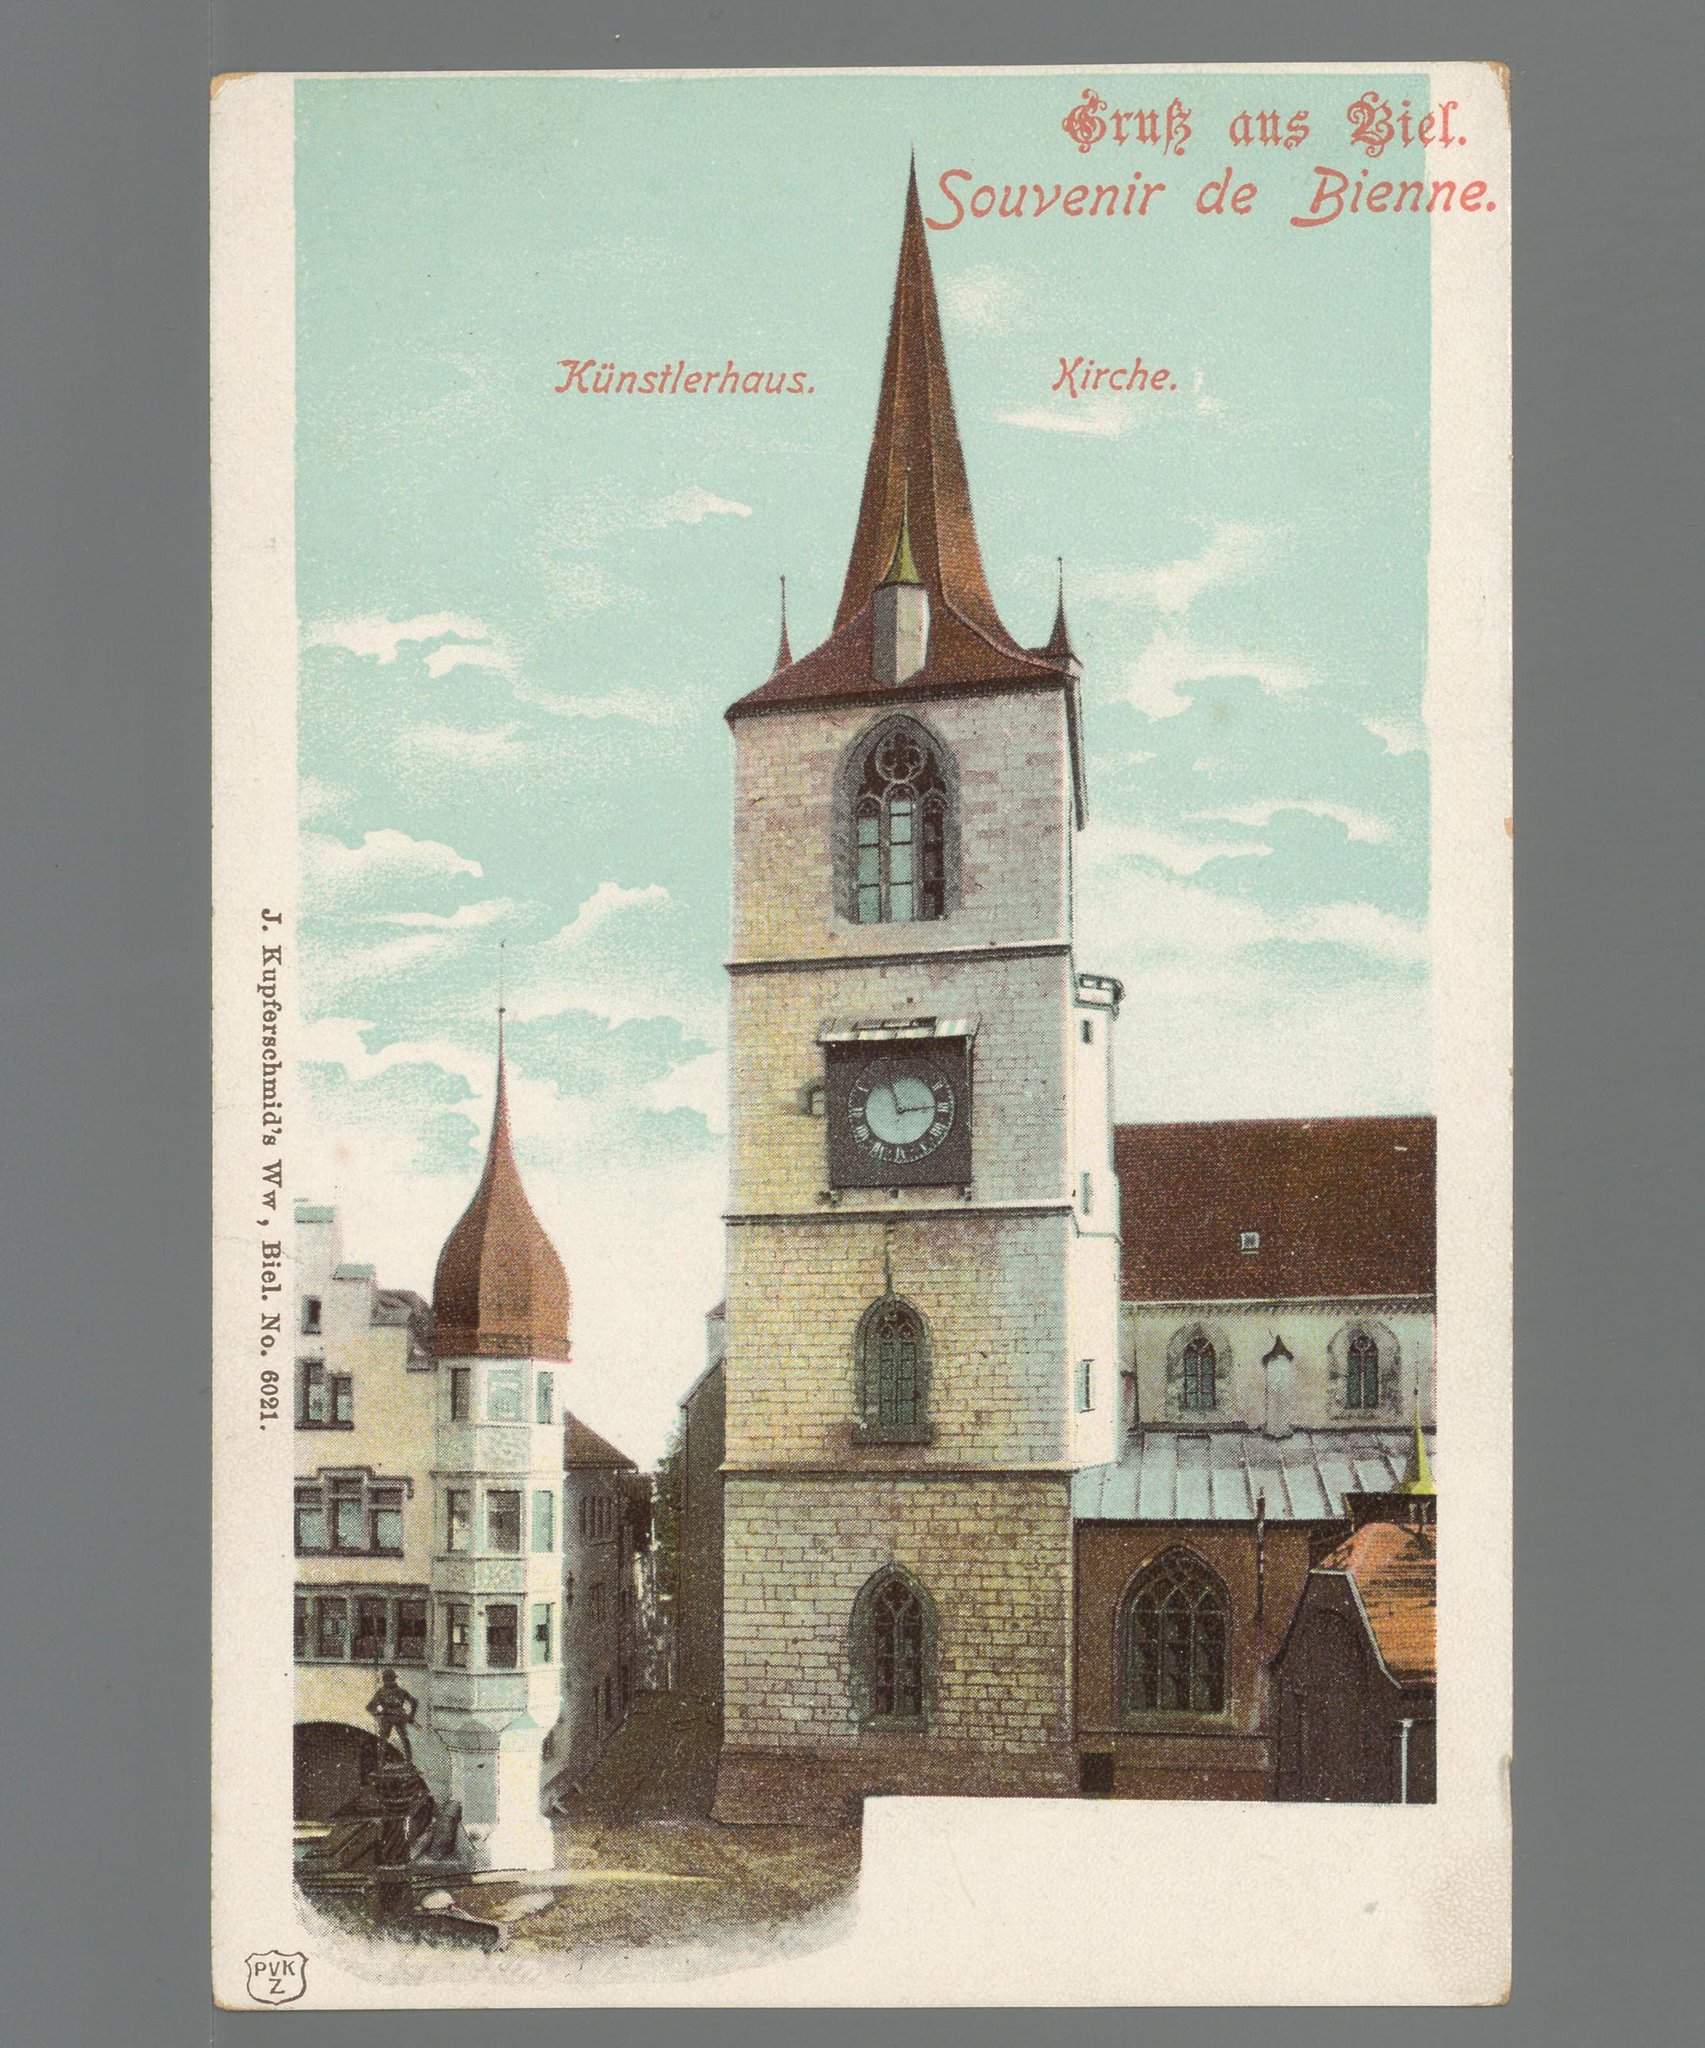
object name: ansichtkaart, prentbriefkaart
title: Gruss aus Biel / Souvenir de Bienne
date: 1890-1905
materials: cardboard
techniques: lithograph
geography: zurich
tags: prospect of village, silhouette of village, church (exterior)